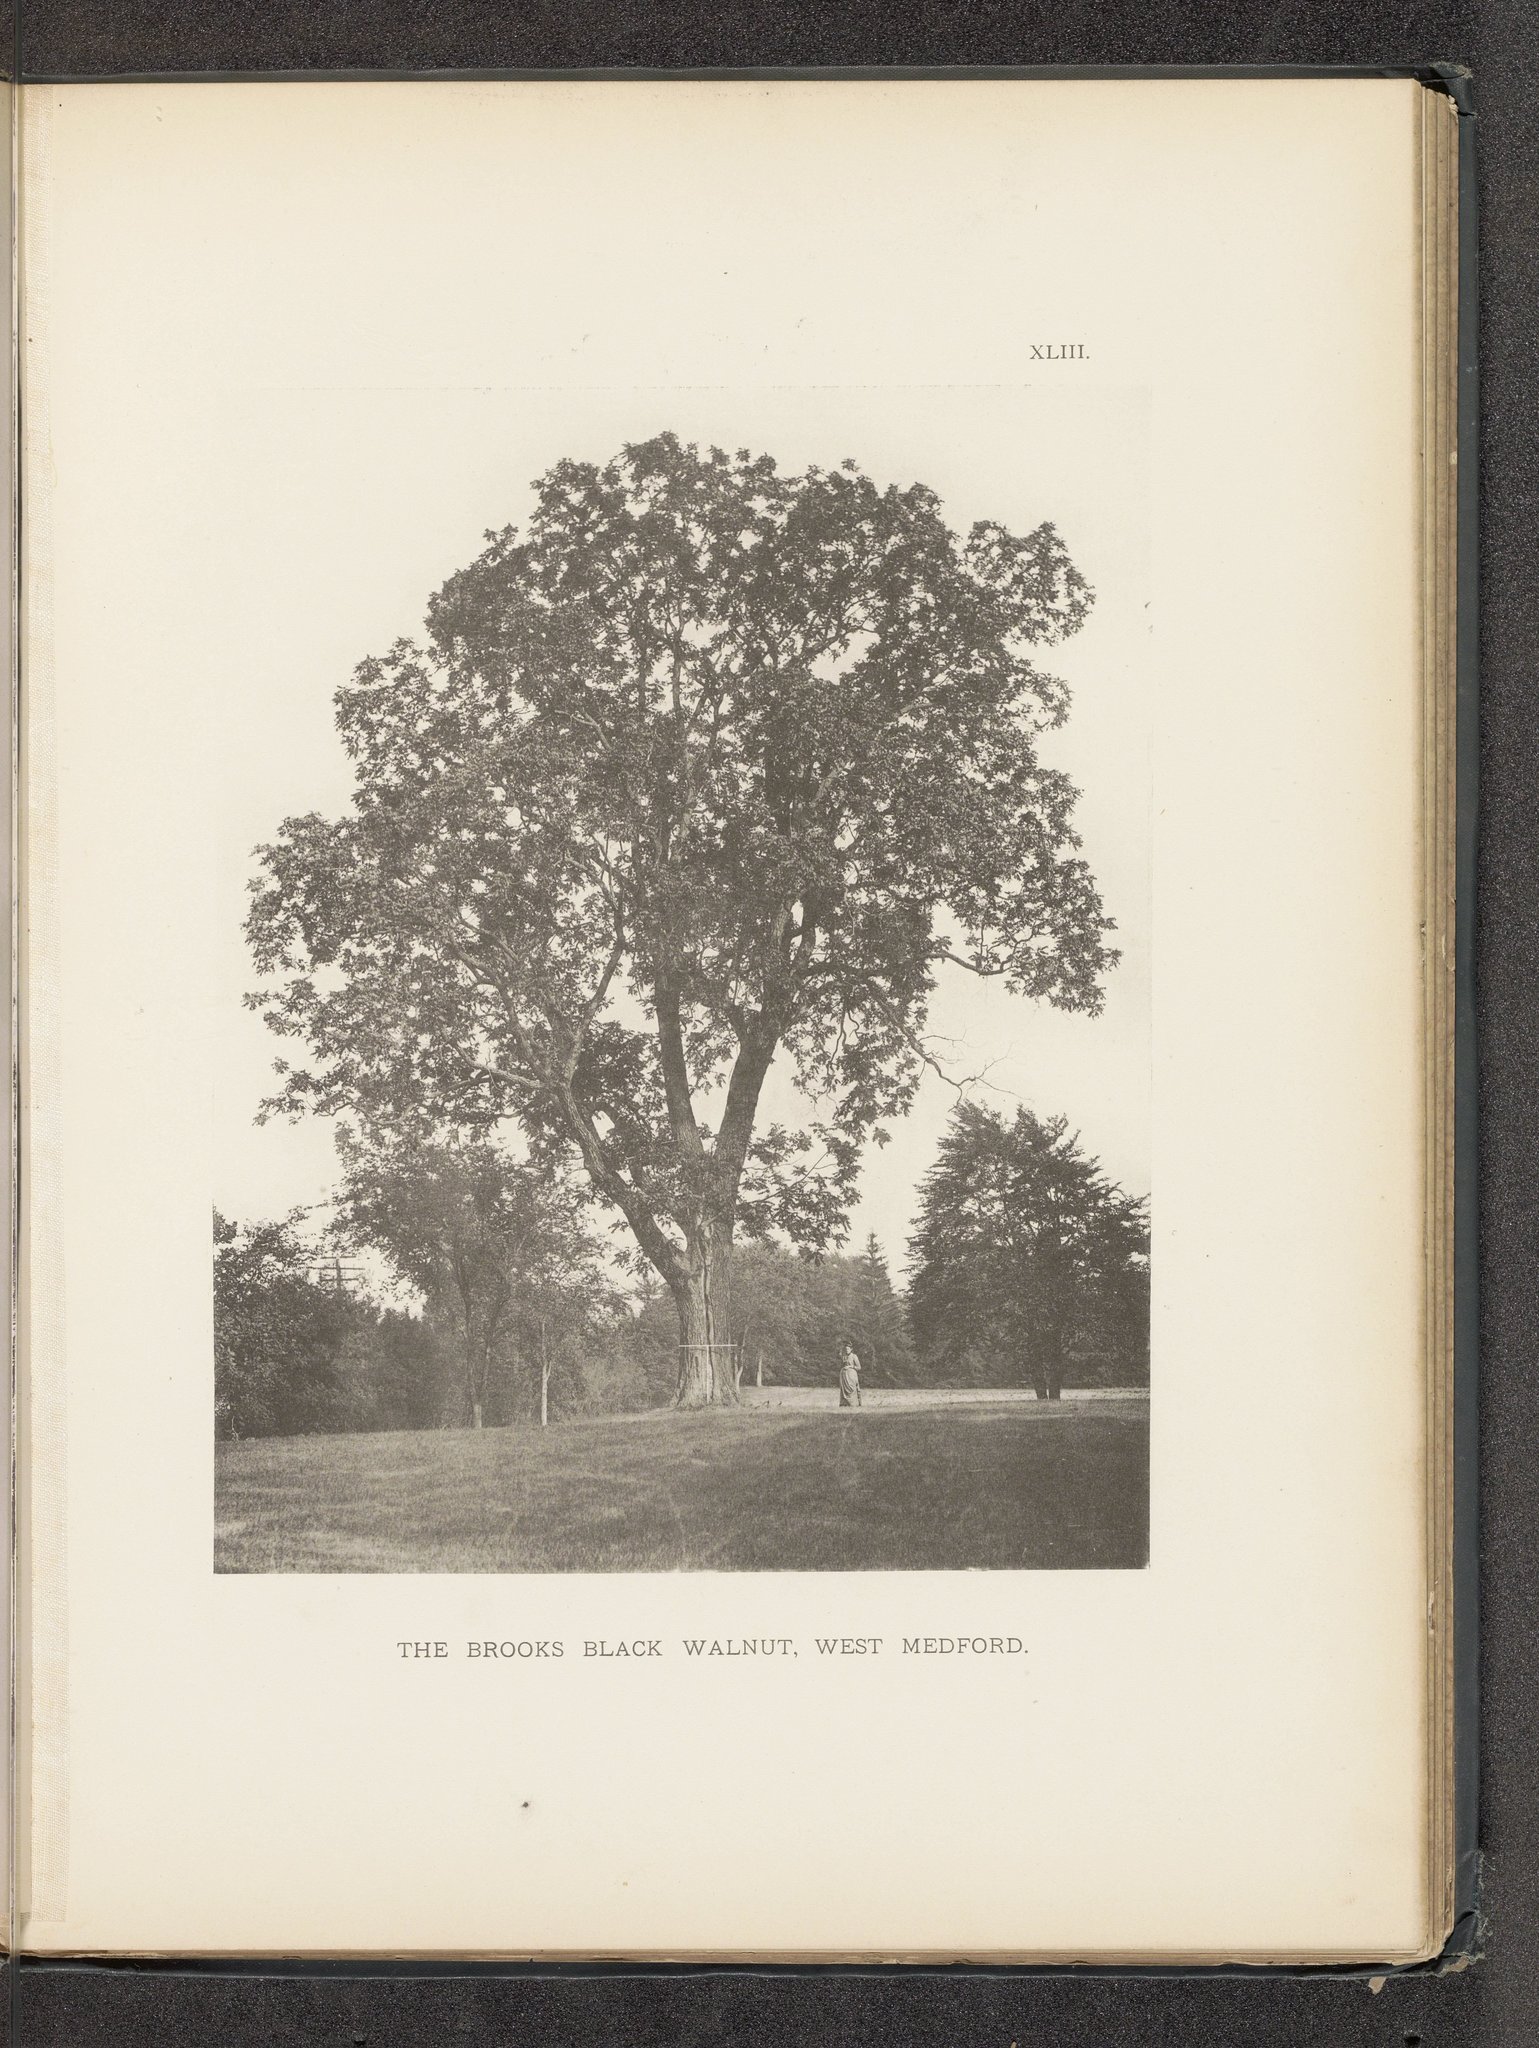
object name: page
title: The Brooks black walnut, West Medford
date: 1880-1890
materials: paper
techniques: photograph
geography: united states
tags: trees: walnut-tree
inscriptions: number: ‘XLIII.’